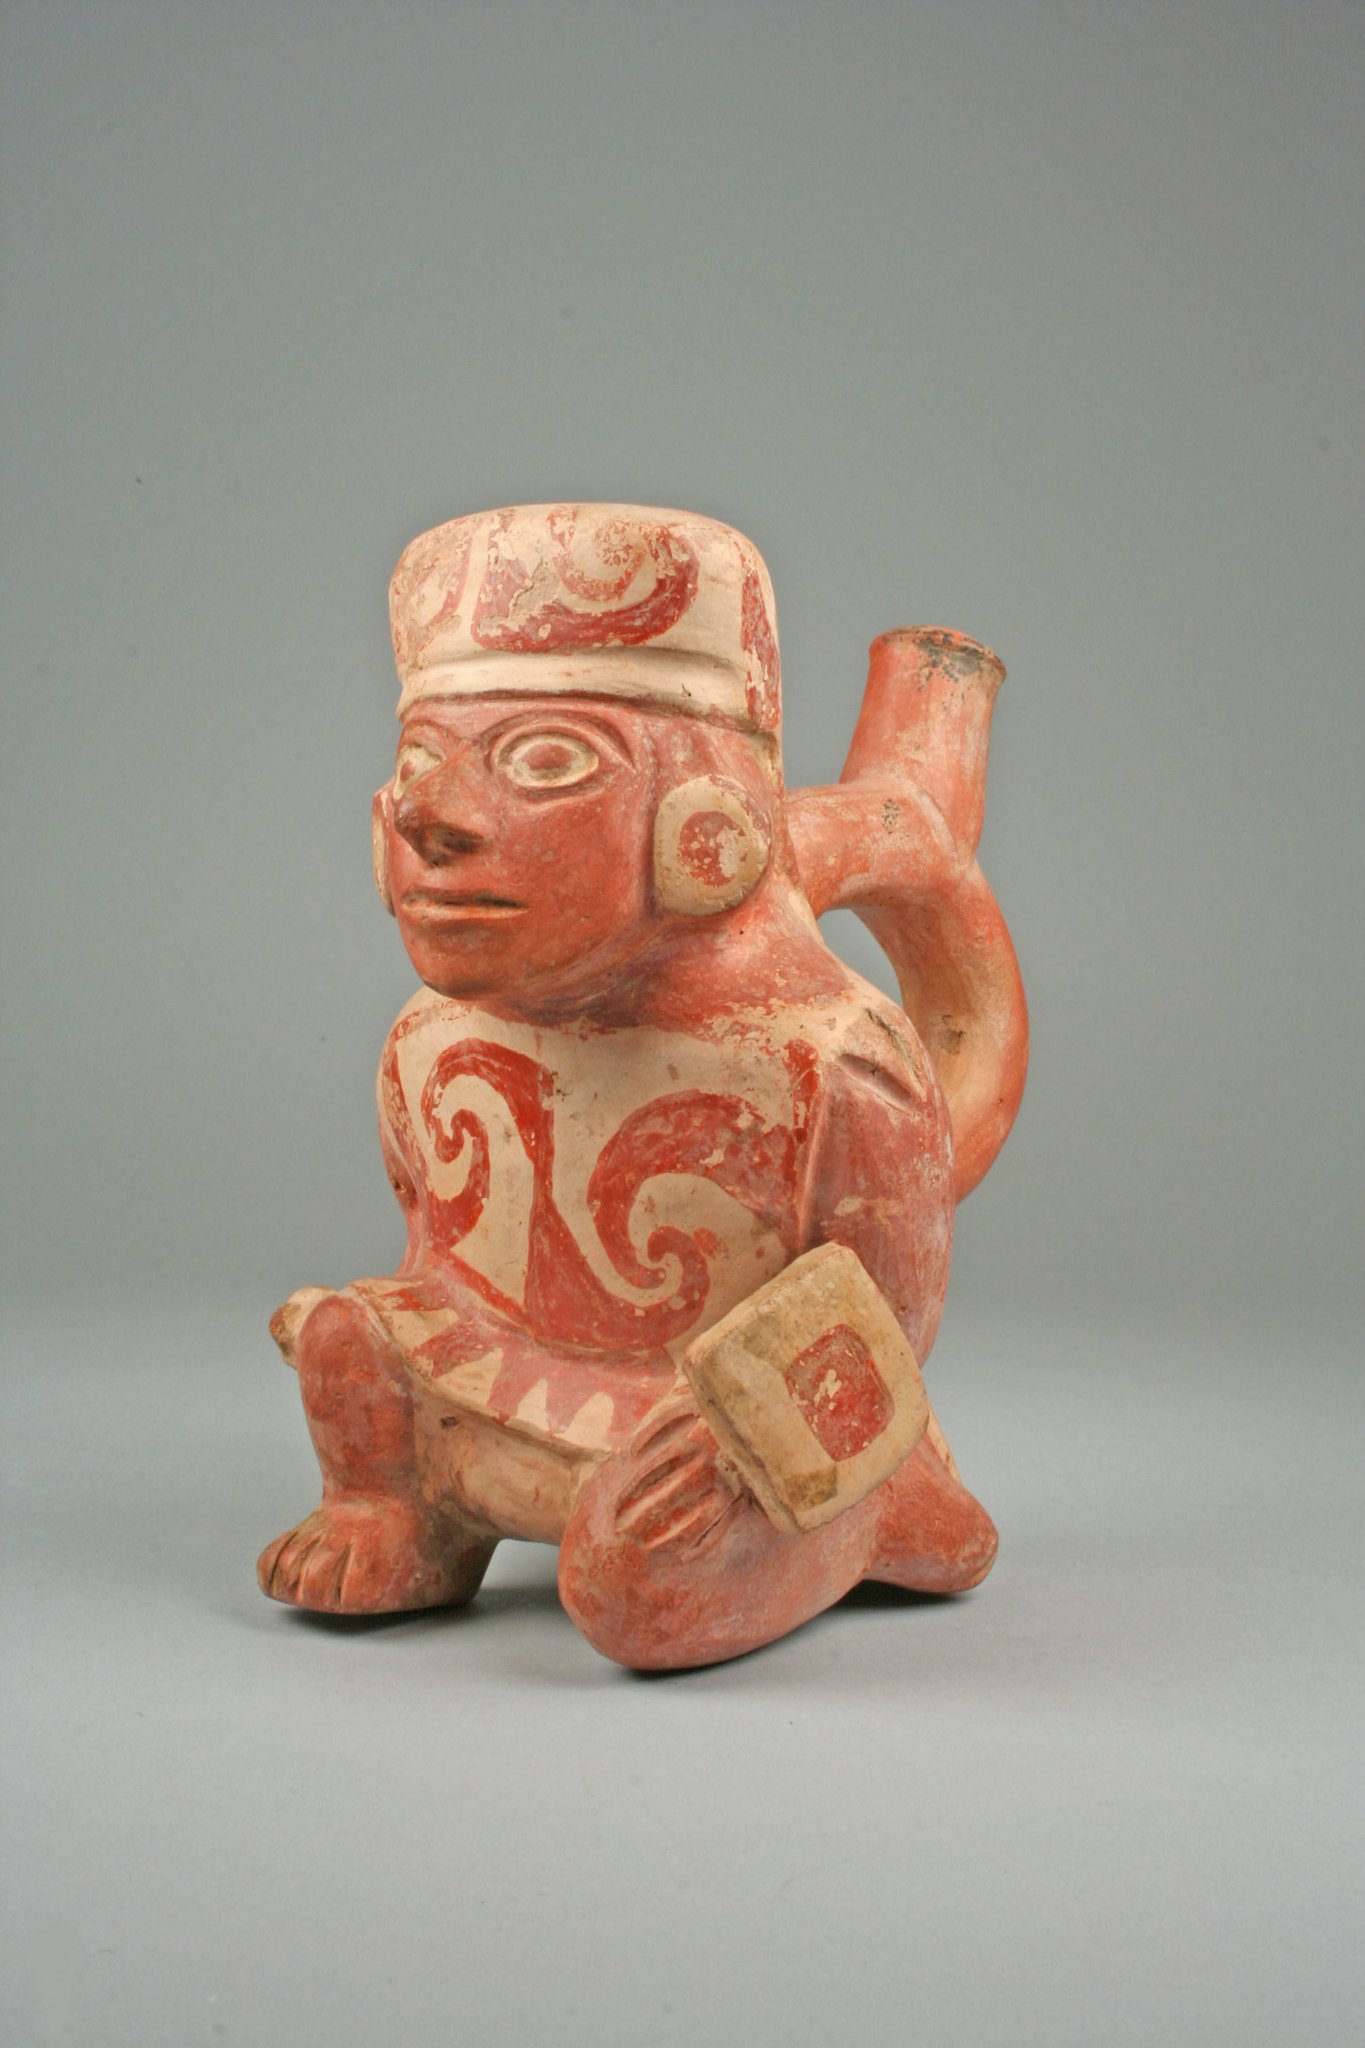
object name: bottle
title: Stirrup Spout Bottle with Warrior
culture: moche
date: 501-700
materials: ceramic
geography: peru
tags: warriors